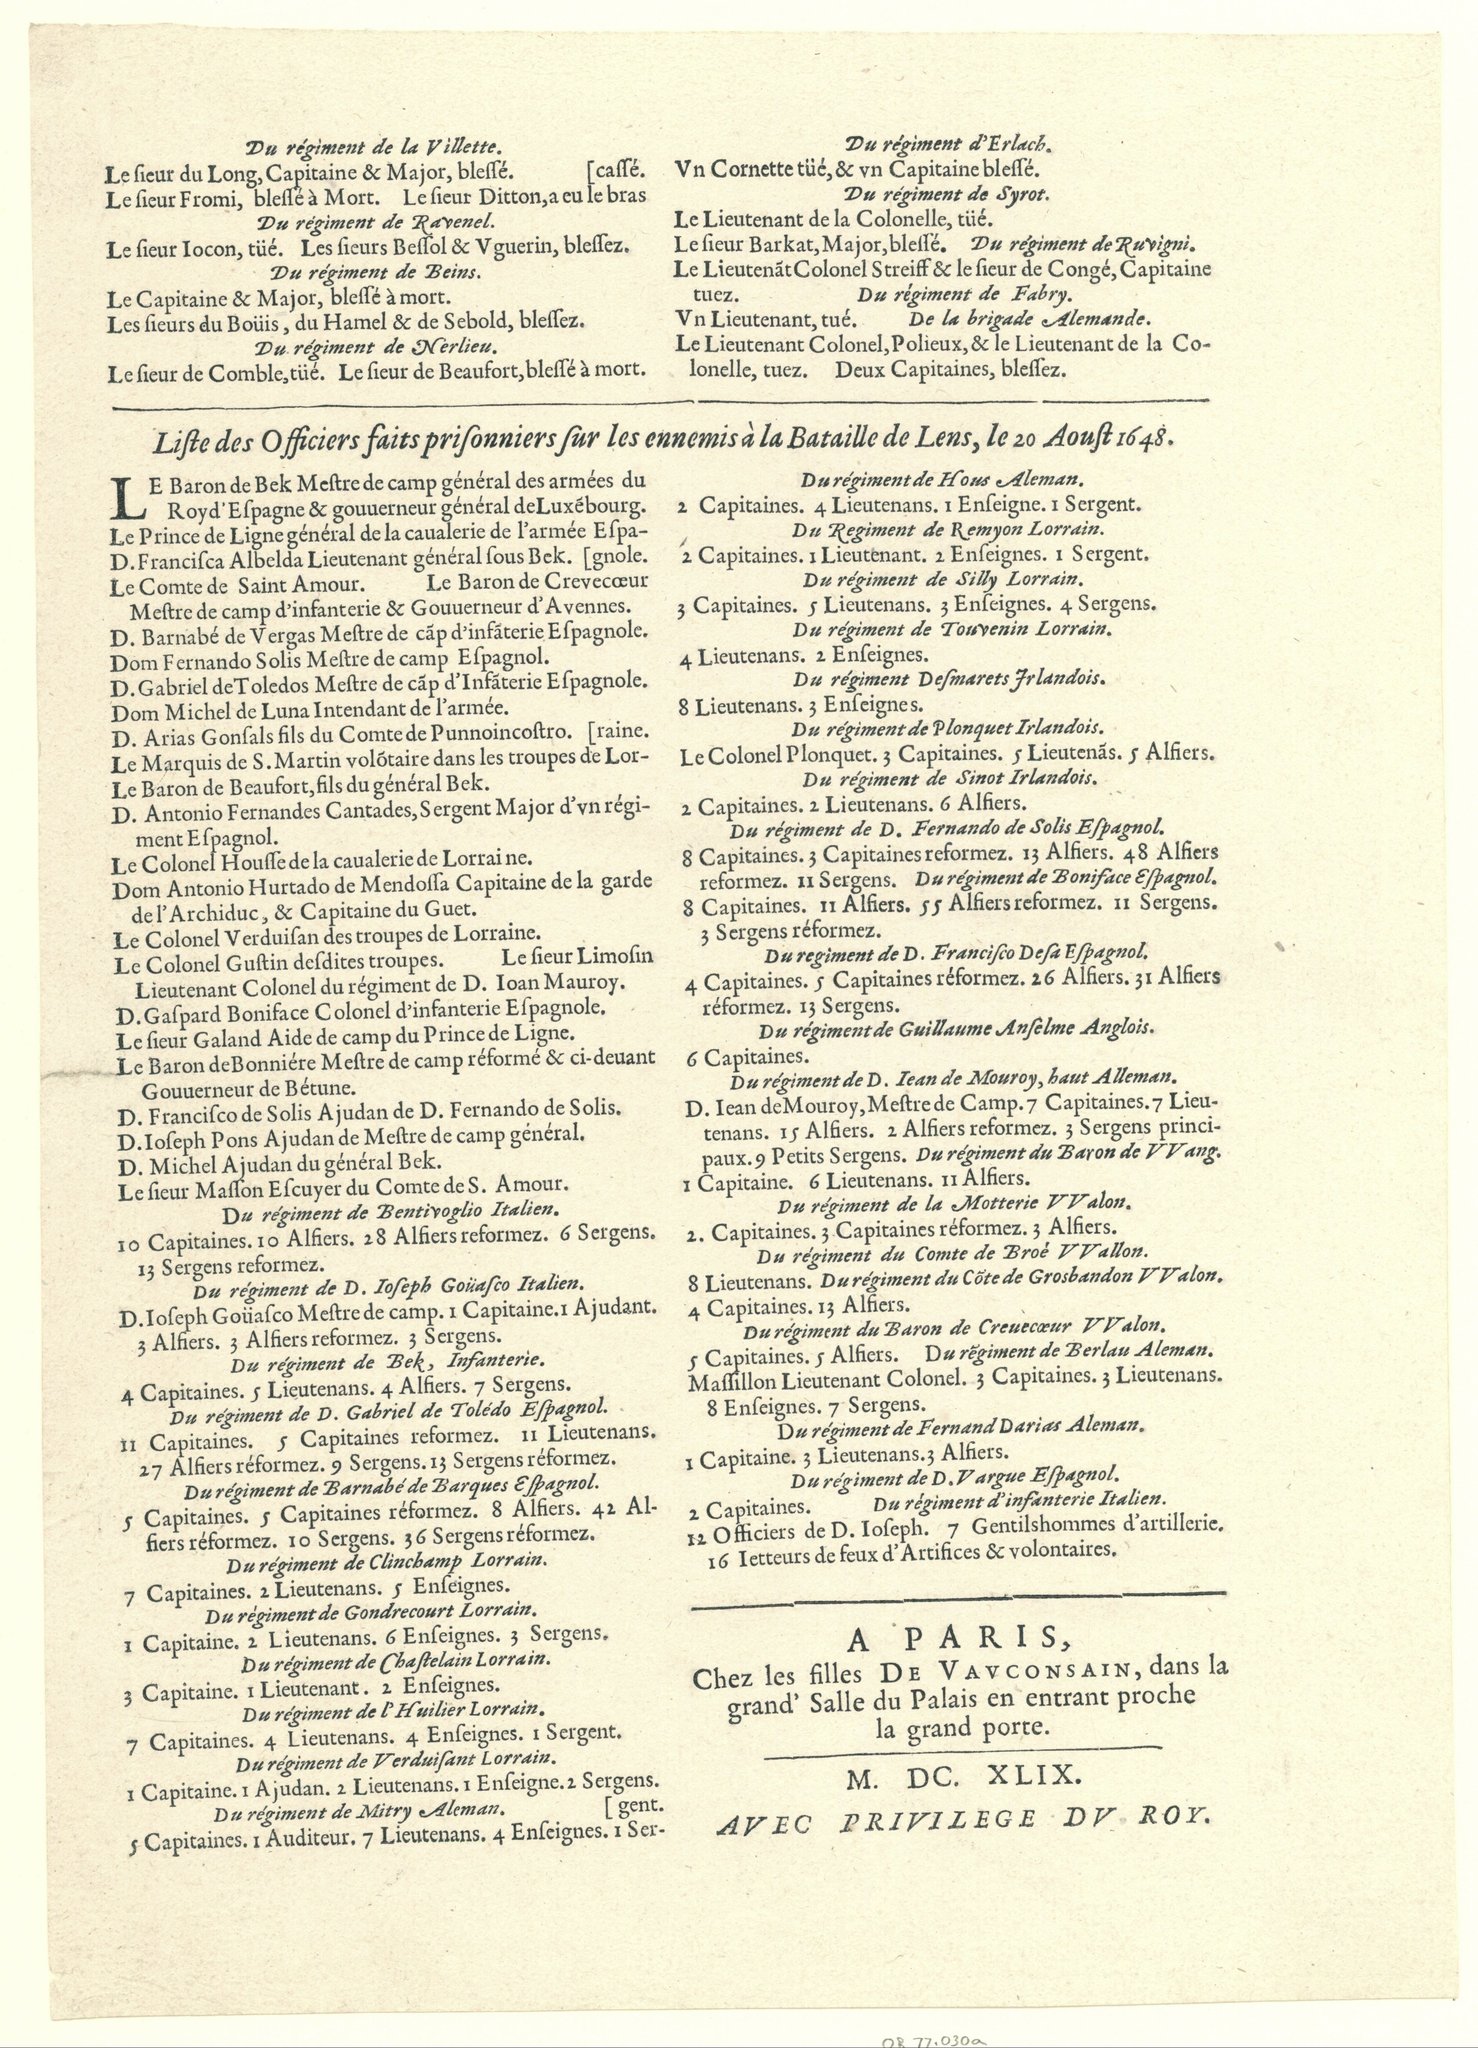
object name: text sheet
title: Tekstblad met een lijst van de namen van de Spaanse officieren gewond of gevangengenomen tijdens de slag bij Lens, 1648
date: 1649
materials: paper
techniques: letterpress printing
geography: paris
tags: vienna, leopold willem van oostenrijk (landvoogd der zuidelijke nederlanden), paris, lodewijk ii de bourbon-condé (hertog van enghien)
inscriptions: collector's mark: Lugt 240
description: Frans tekstblad met een lijst van de namen van de Spaanse officieren die gewond zijn geraakt of door de Fransen gevangen zijn genomen tijdens de veldslag bij Lens op 20 augustus 1648. Waarschijnlijk is dit het tweede deel van een lijst waarvan het eerste deel met de lijst van de gesneuvelden ontbreekt.